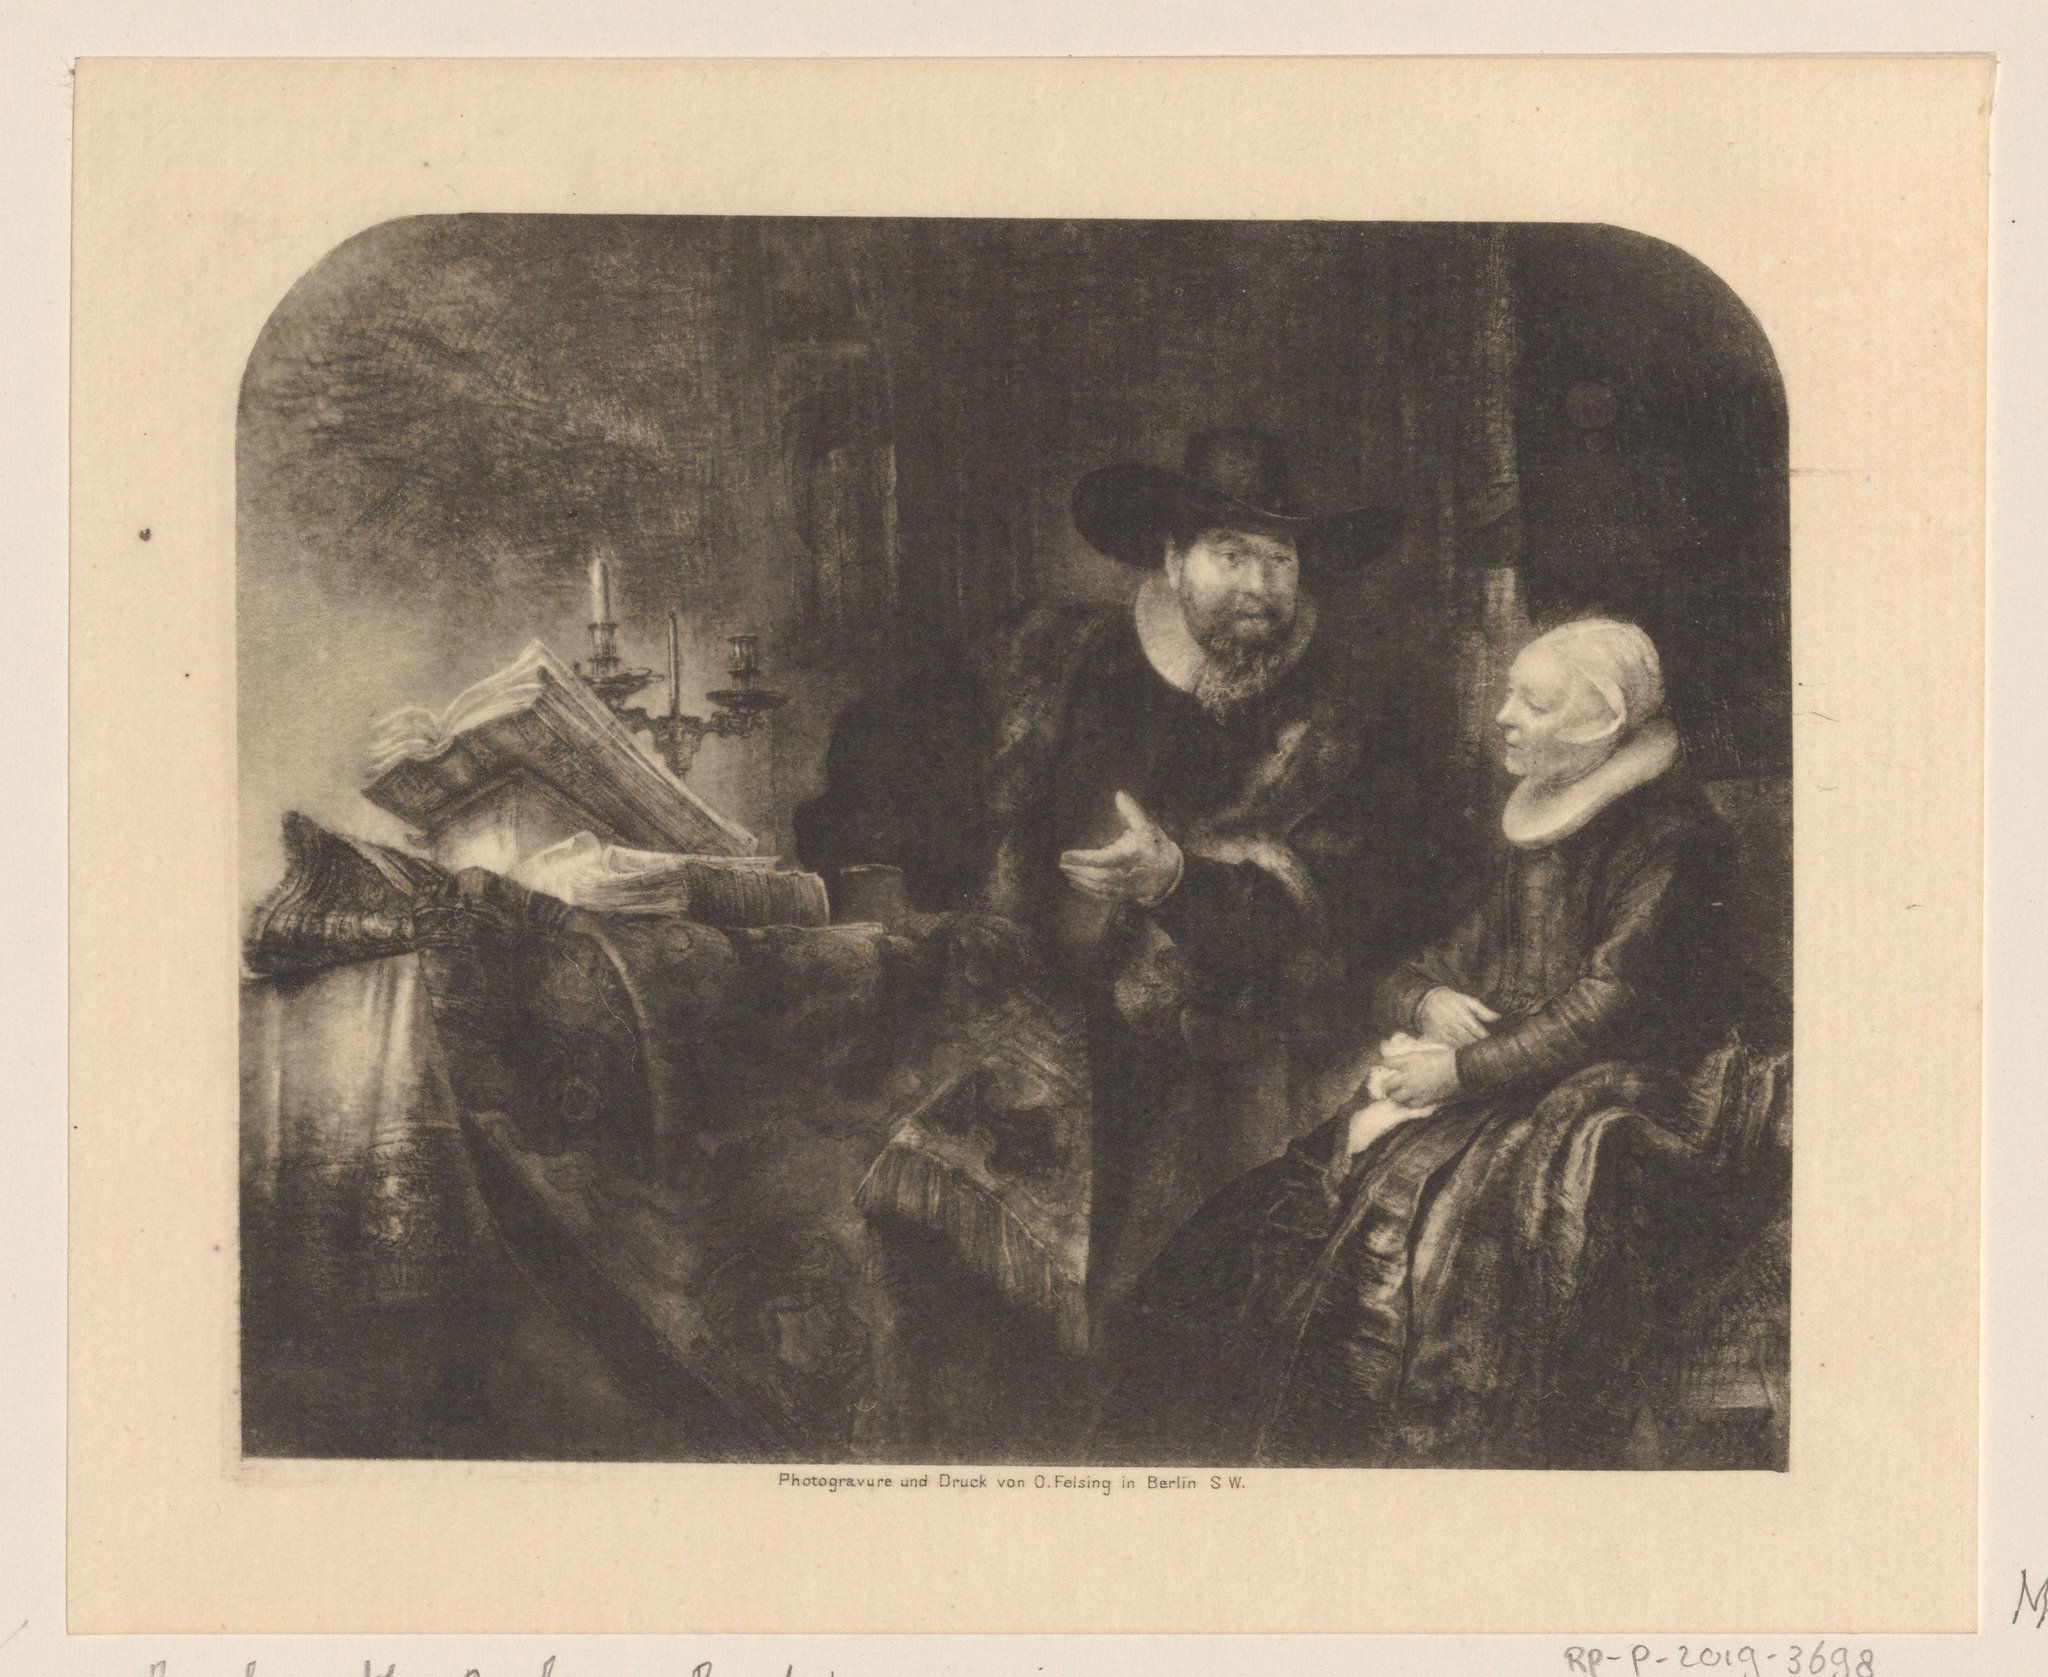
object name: photomechanical print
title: Portret van Cornelis Claesz. Anslo en zijn vrouw Aaltje Schouten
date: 1875-1920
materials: paper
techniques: photograph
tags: historical persons - bb - woman, historical persons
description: Schilderij in de collectie van de Gemäldegalerie, Berlijn.